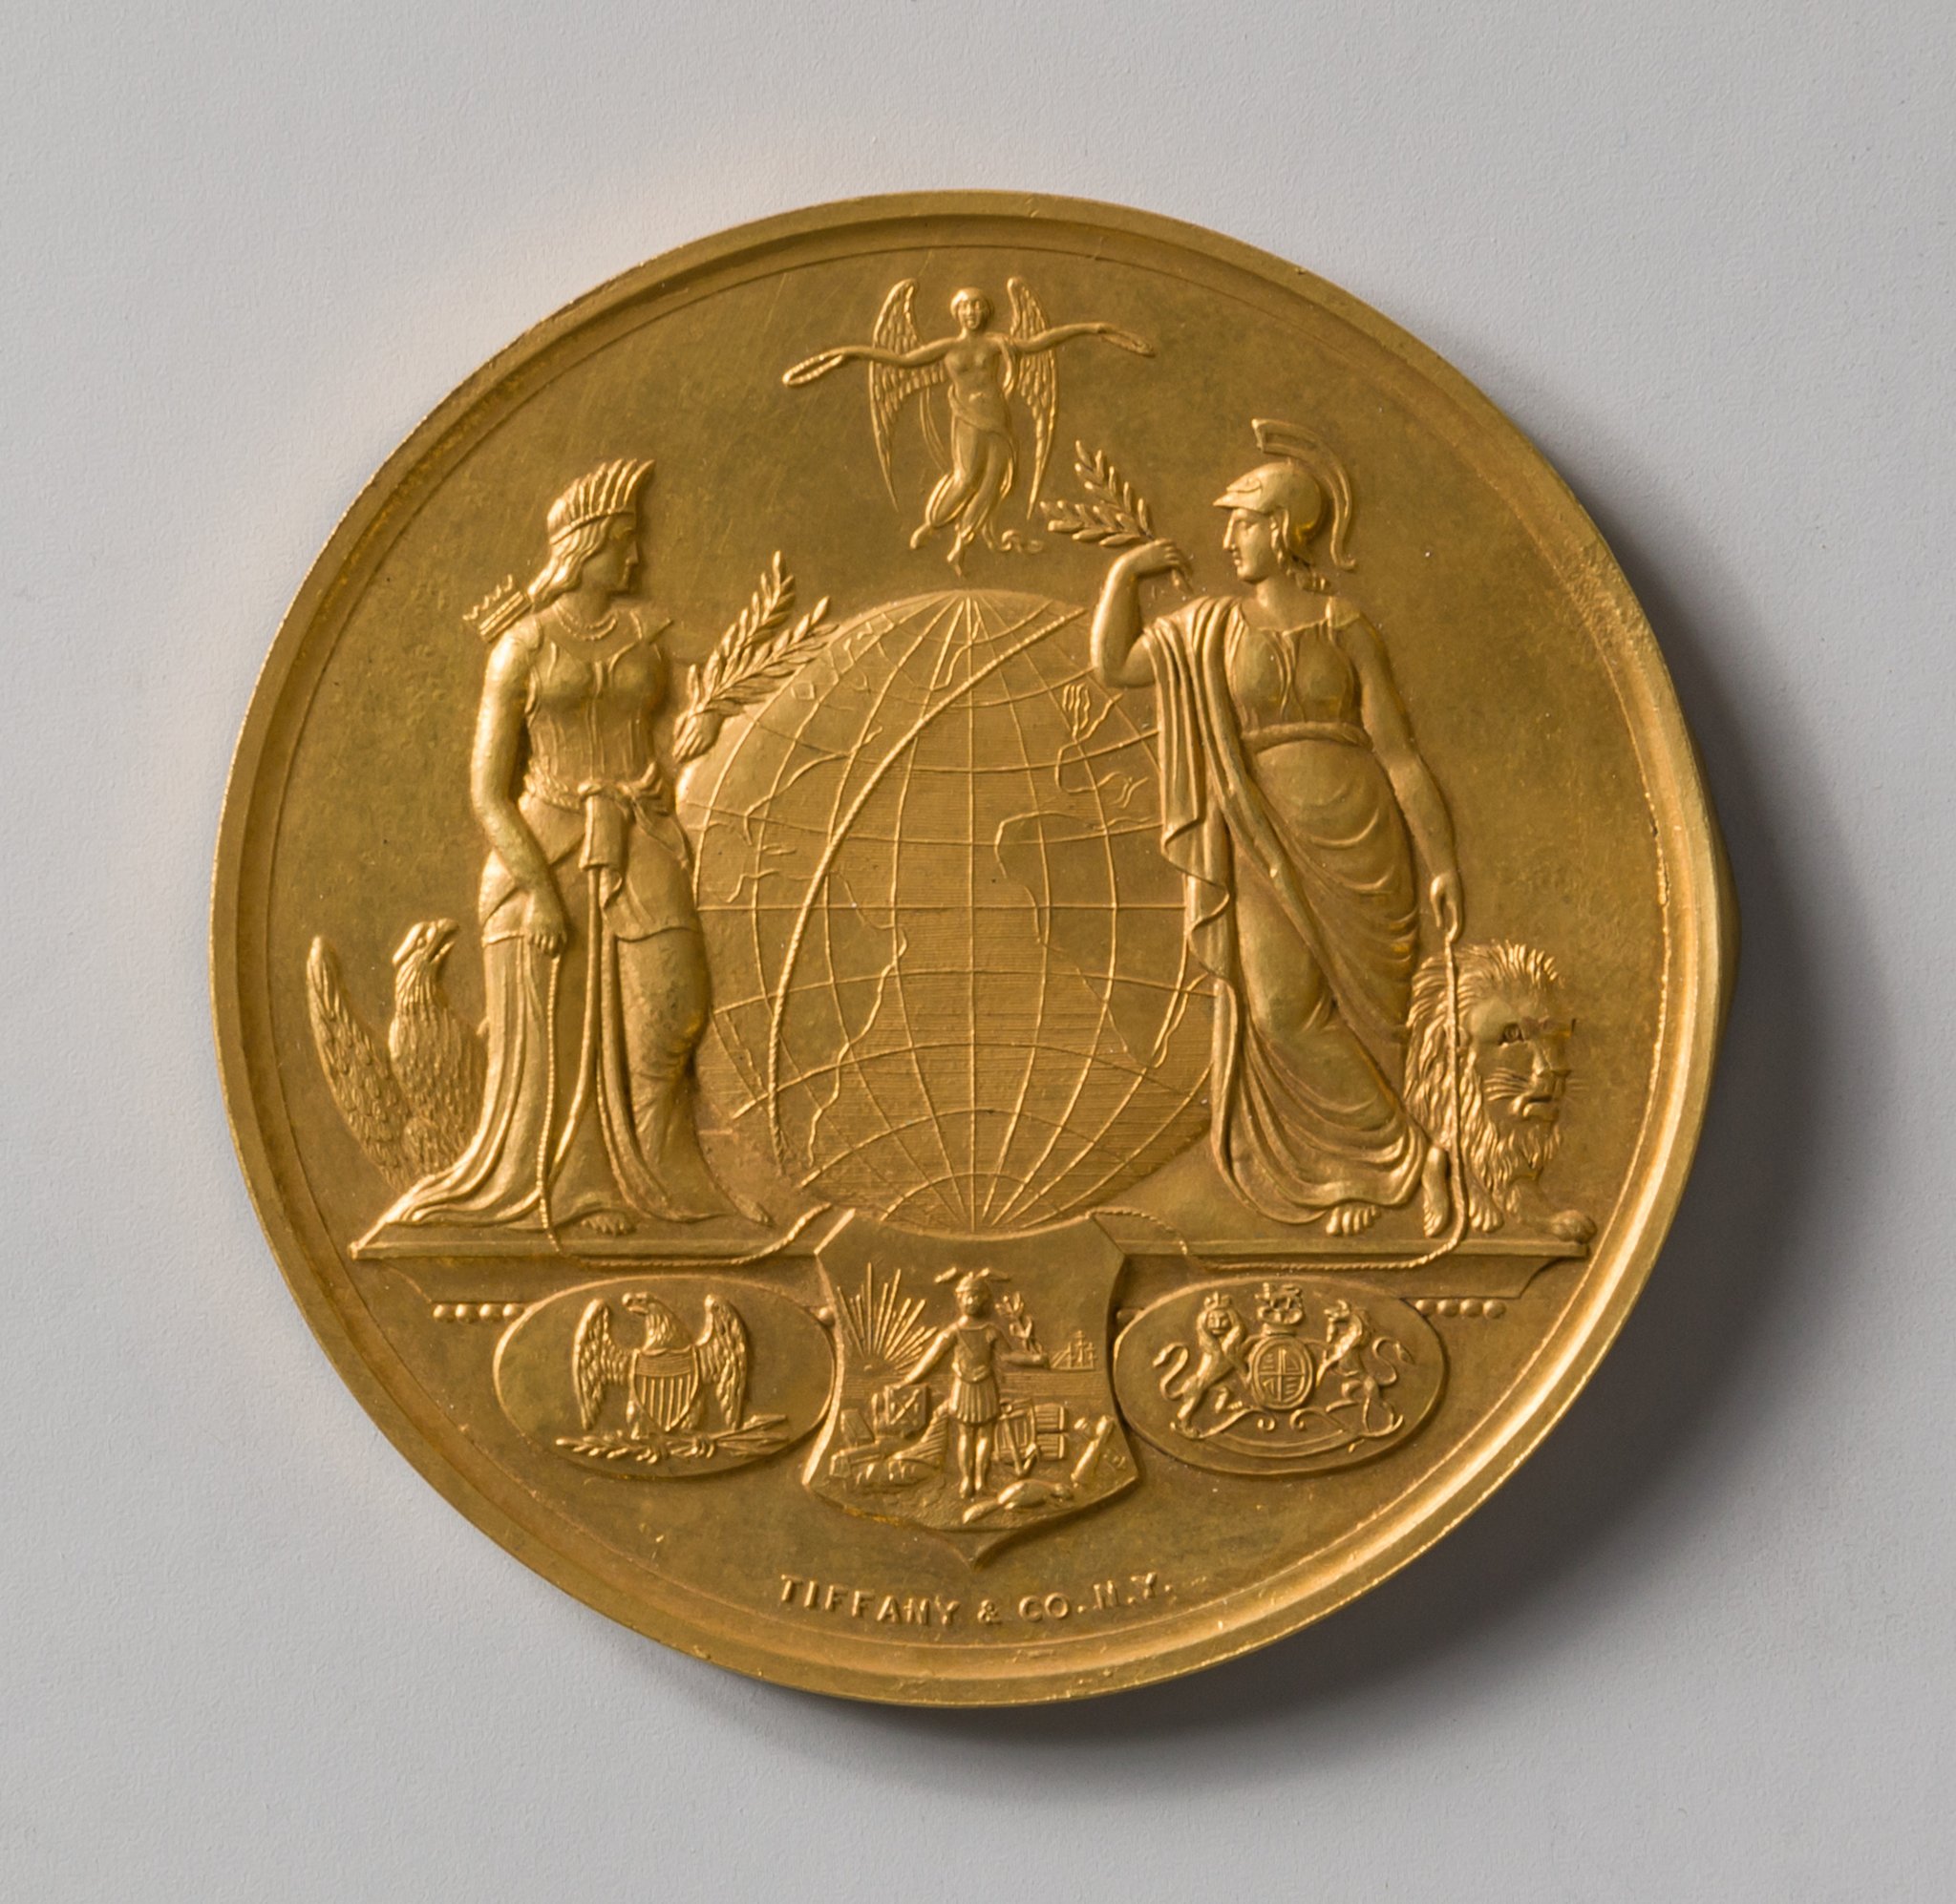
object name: medal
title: Congressional Medal to C. W. Field for the Successful Laying of the Atlantic Cable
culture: american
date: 1867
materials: gold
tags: men,women,lions,globes,transatlantic cable